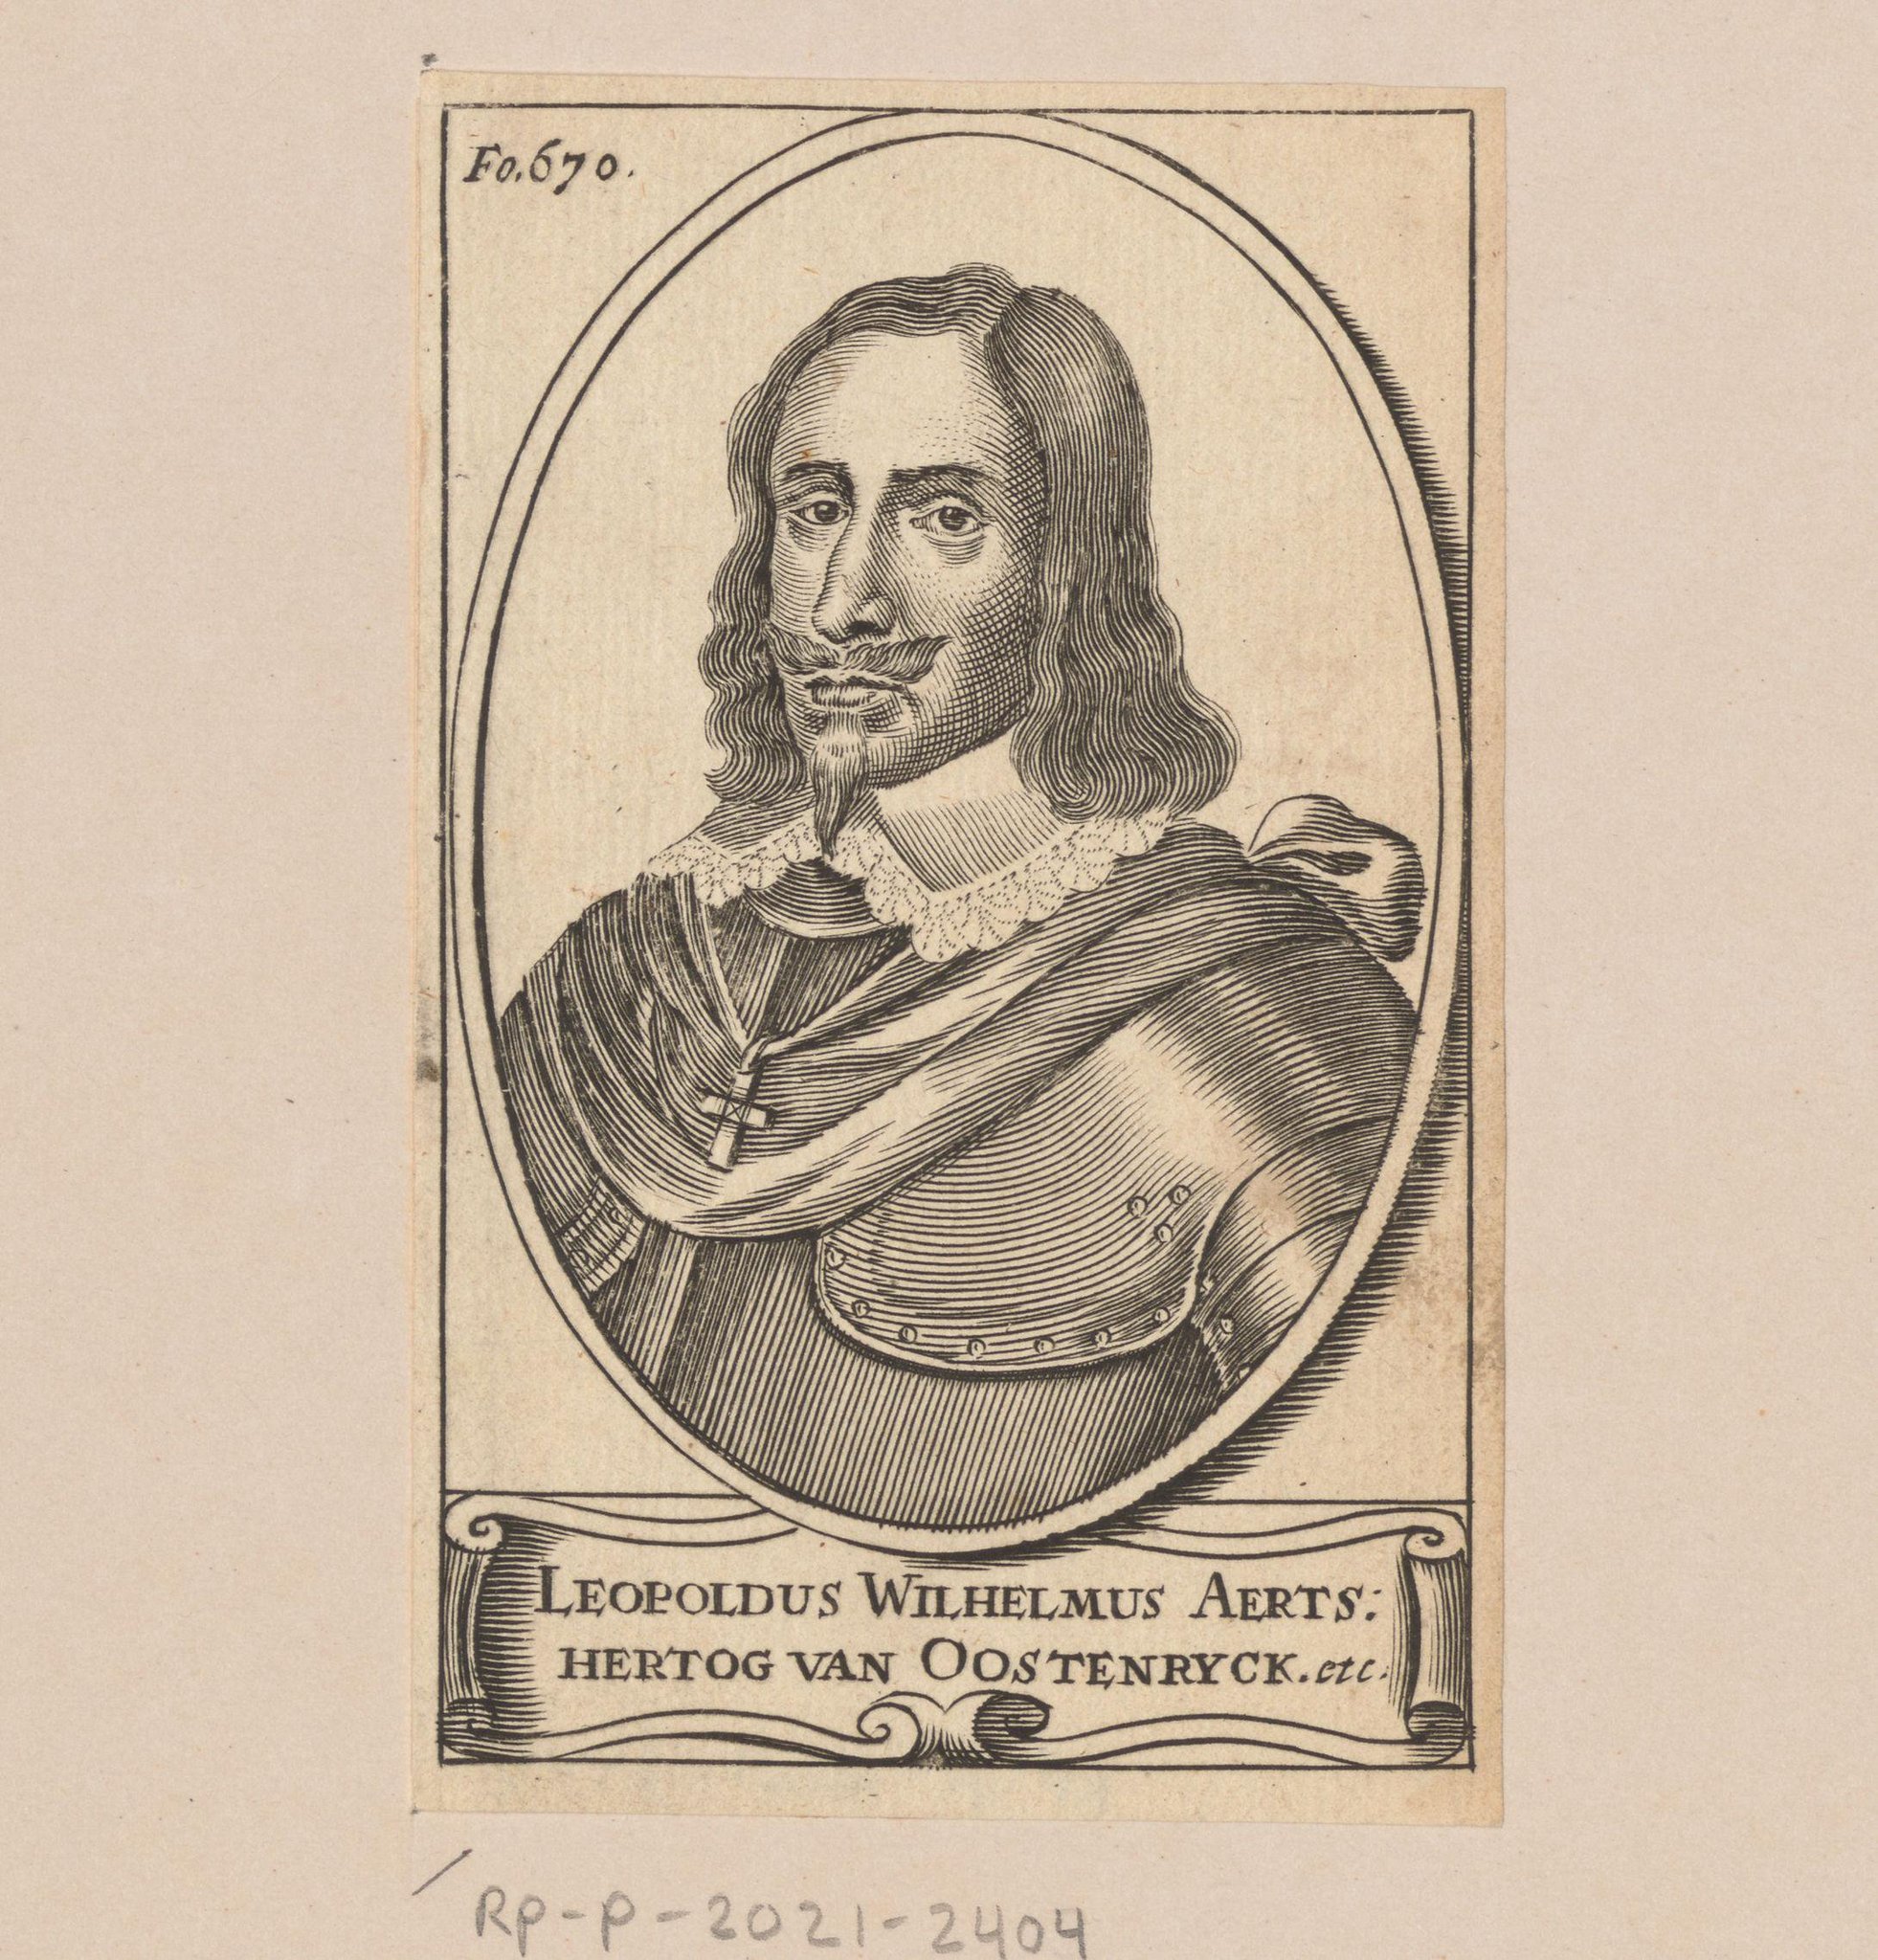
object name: book illustration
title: Portret van Leopold Willem van Oostenrijk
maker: Anonymous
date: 1651-1663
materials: paper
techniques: engraving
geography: northern netherlands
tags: leopold willem van oostenrijk (landvoogd der zuidelijke nederlanden), ornament ~ medallion, armour, historical persons, governor, etc. of province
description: Prent waarschijnlijk uit: Sande, Johan van den. De wakende leeu der Nederlanden (...). Leeuwarden: Gijsbert Sybes, 1651. Of uit de editie uit 1663, uitgegeven in Amsterdam.